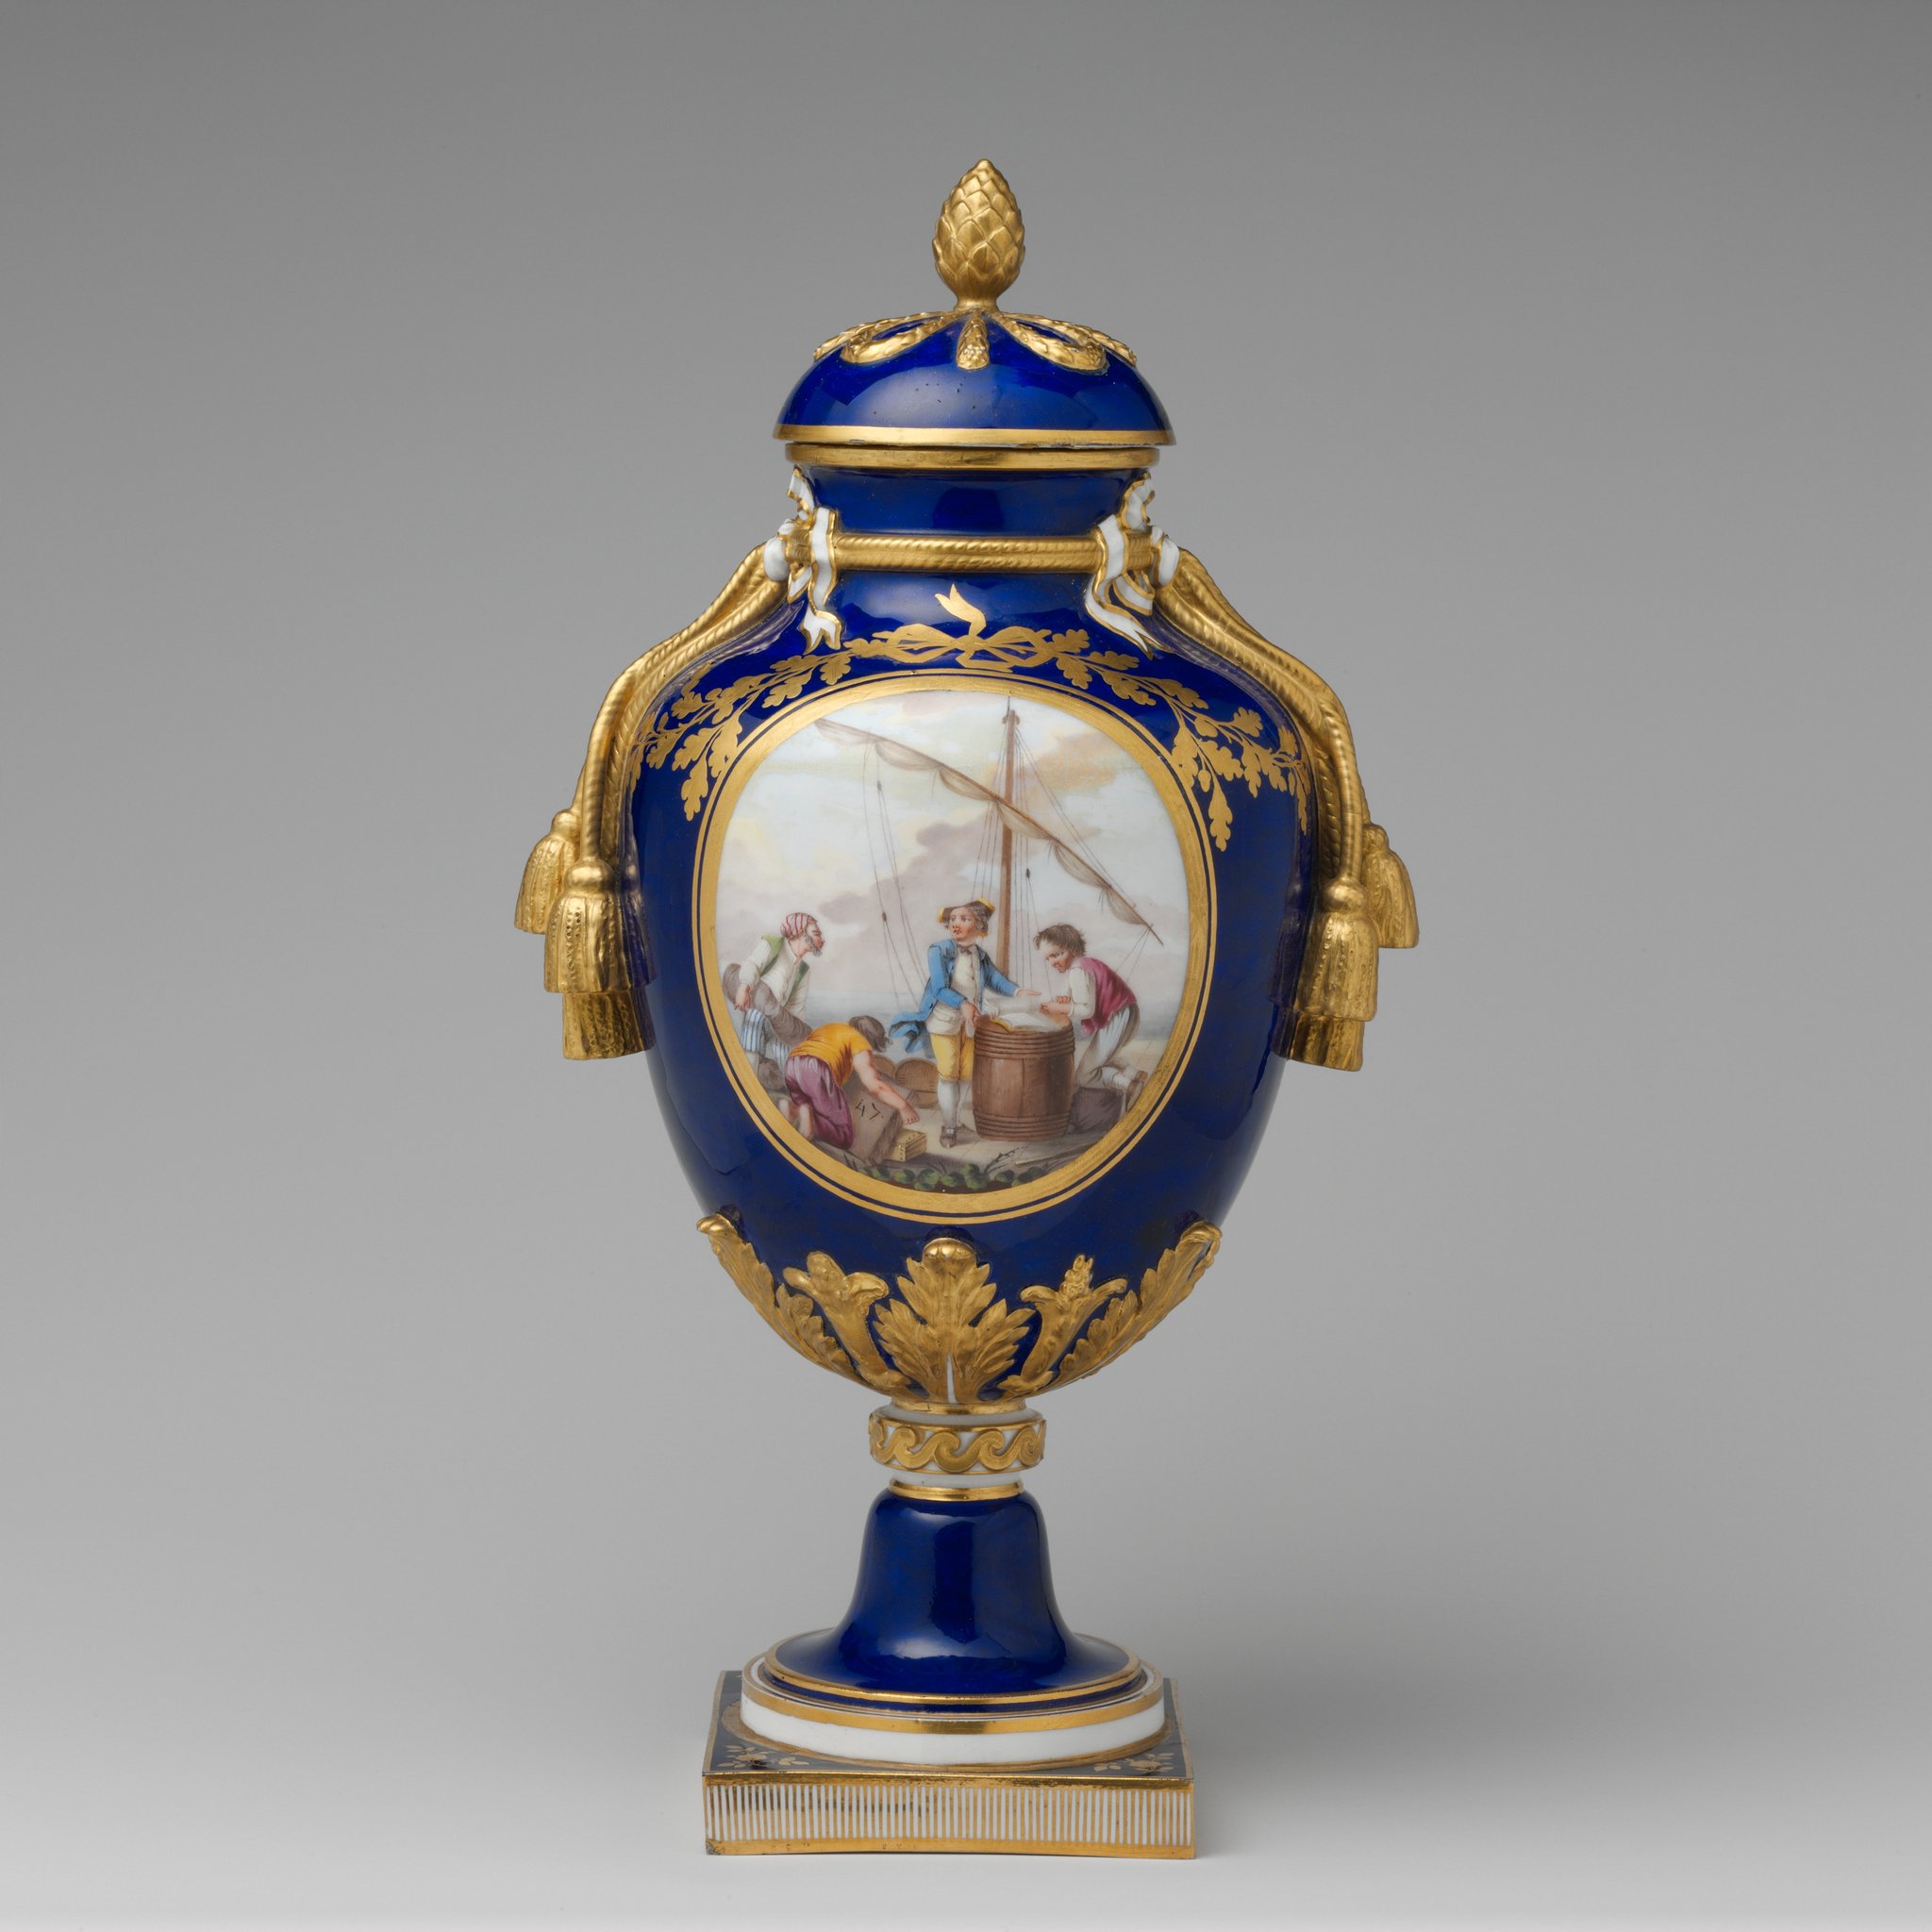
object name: vase with cover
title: Vase with cover (vase à gland) (one of a pair)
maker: sèvres manufactory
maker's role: manufactory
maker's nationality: french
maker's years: 1740-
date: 1775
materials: soft paste porcelain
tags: men,merchants,sailors